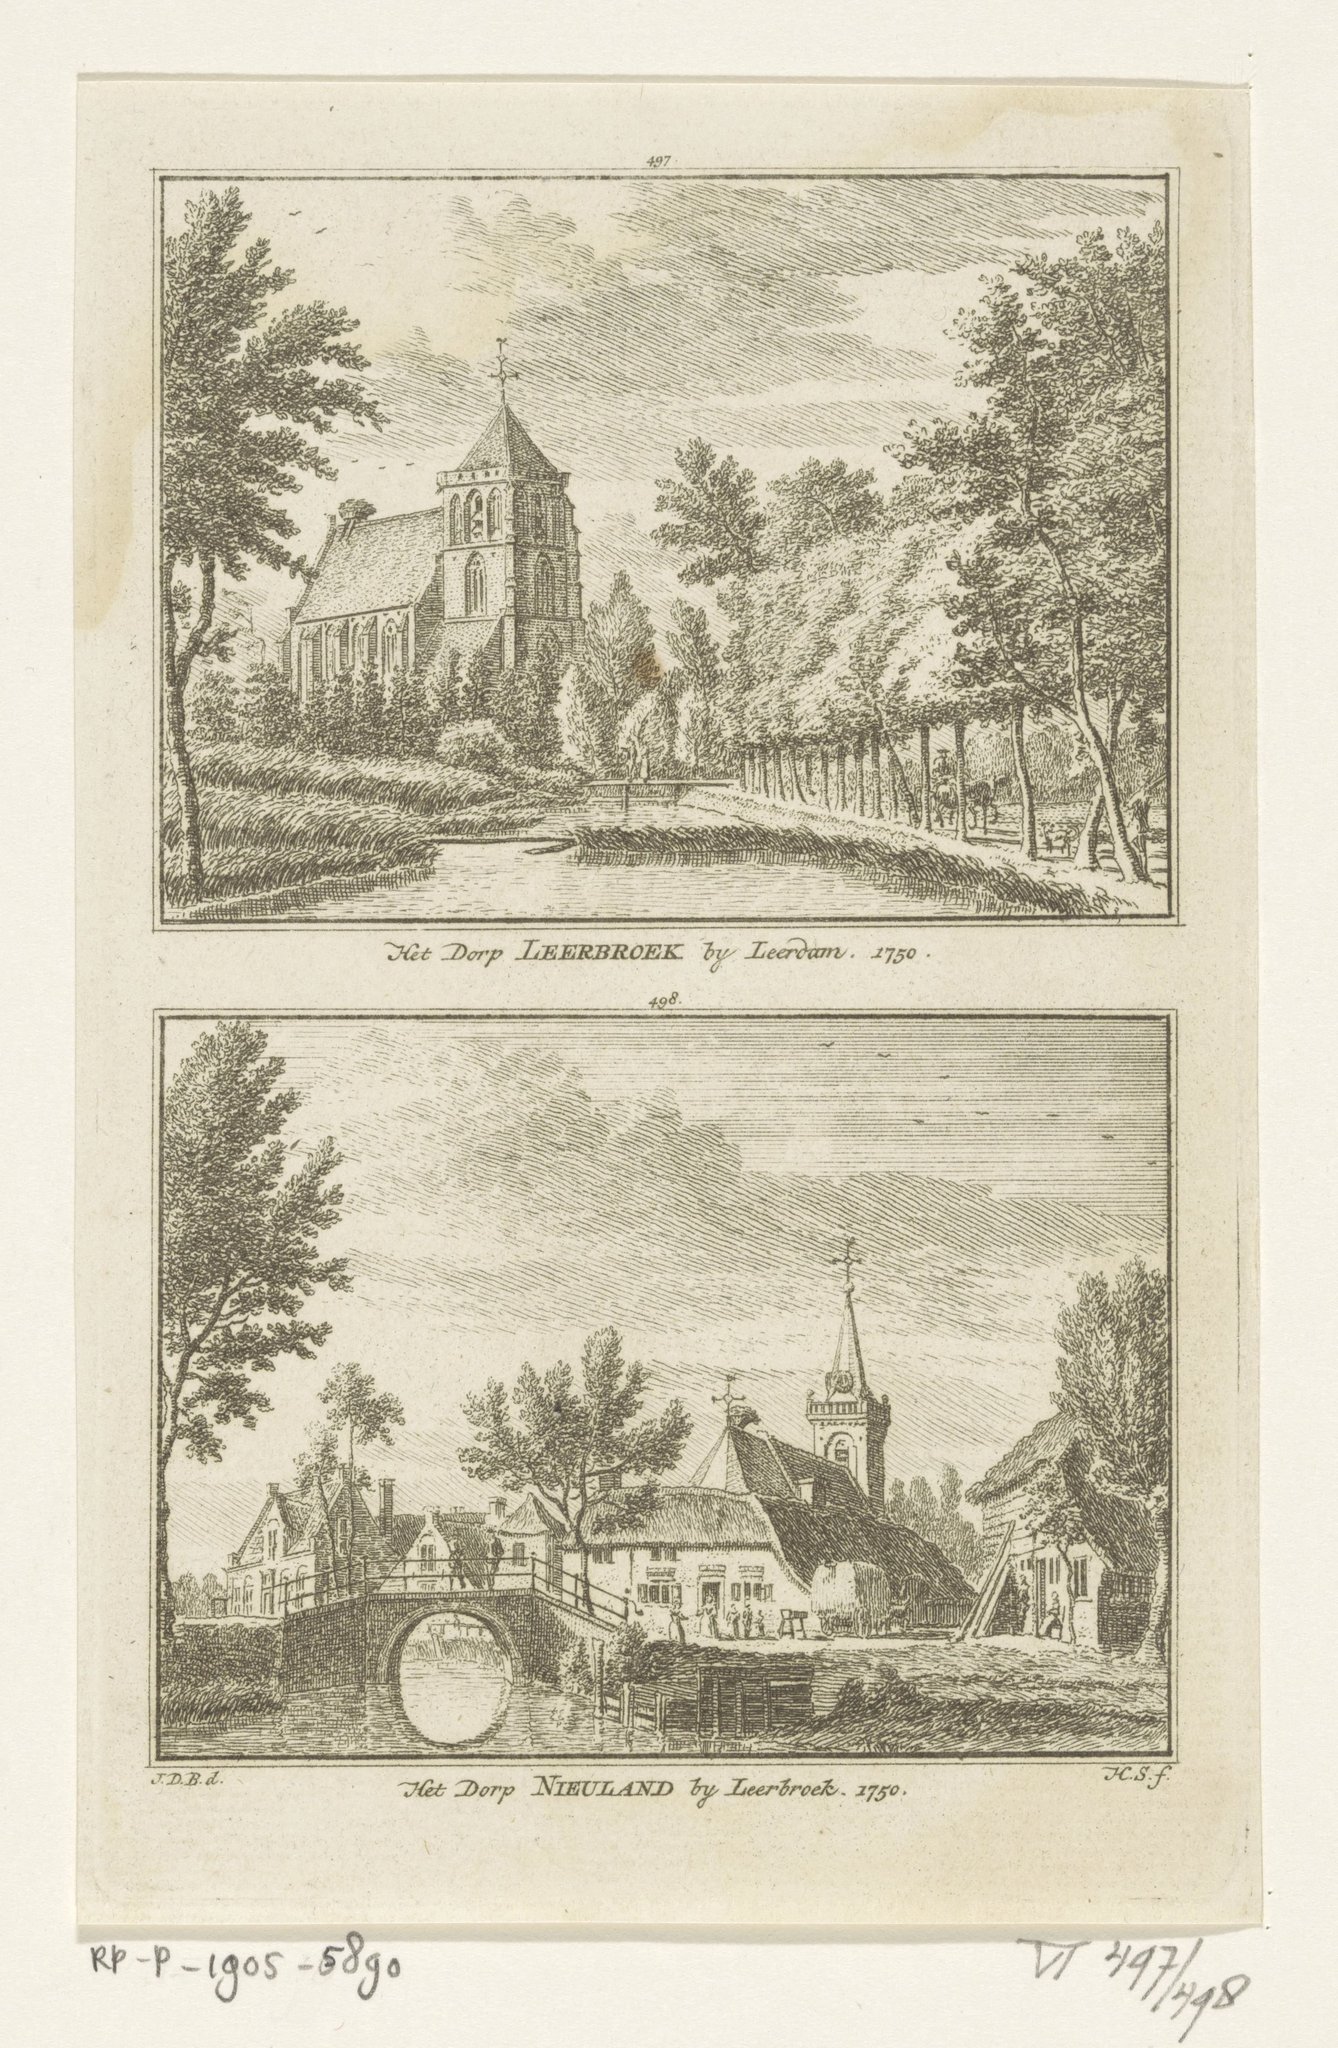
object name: book illustration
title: Het Dorp Leerbroek by Leerdam 1750/ Het Dorp Nieuland by Leerbroek 1750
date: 1757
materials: paper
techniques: etching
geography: haarlem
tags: church (exterior), public road in village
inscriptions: collector's mark: Lugt 2228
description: Prent gebruikt in: Het verheerlykt Nederland of kabinet van hedendaagsche gezigten van steden, dorpen, sloten ... en andere voornaame stad- en landgebouwen, in en omtrent alle de byzondere Vereenigde Nederlandsche Provinciën : gedurende de laatste jaaren door vermaarden kunsttekenaren na het leven getekent en ... in 't koper gebragt ... dienende tot opheldering der beschryvinge van den Tegenwoordigen Staat der Vereenigde Nederlanden. Deel VI, 1757. Amsterdam: Isaac Tirion, 1745-1774.